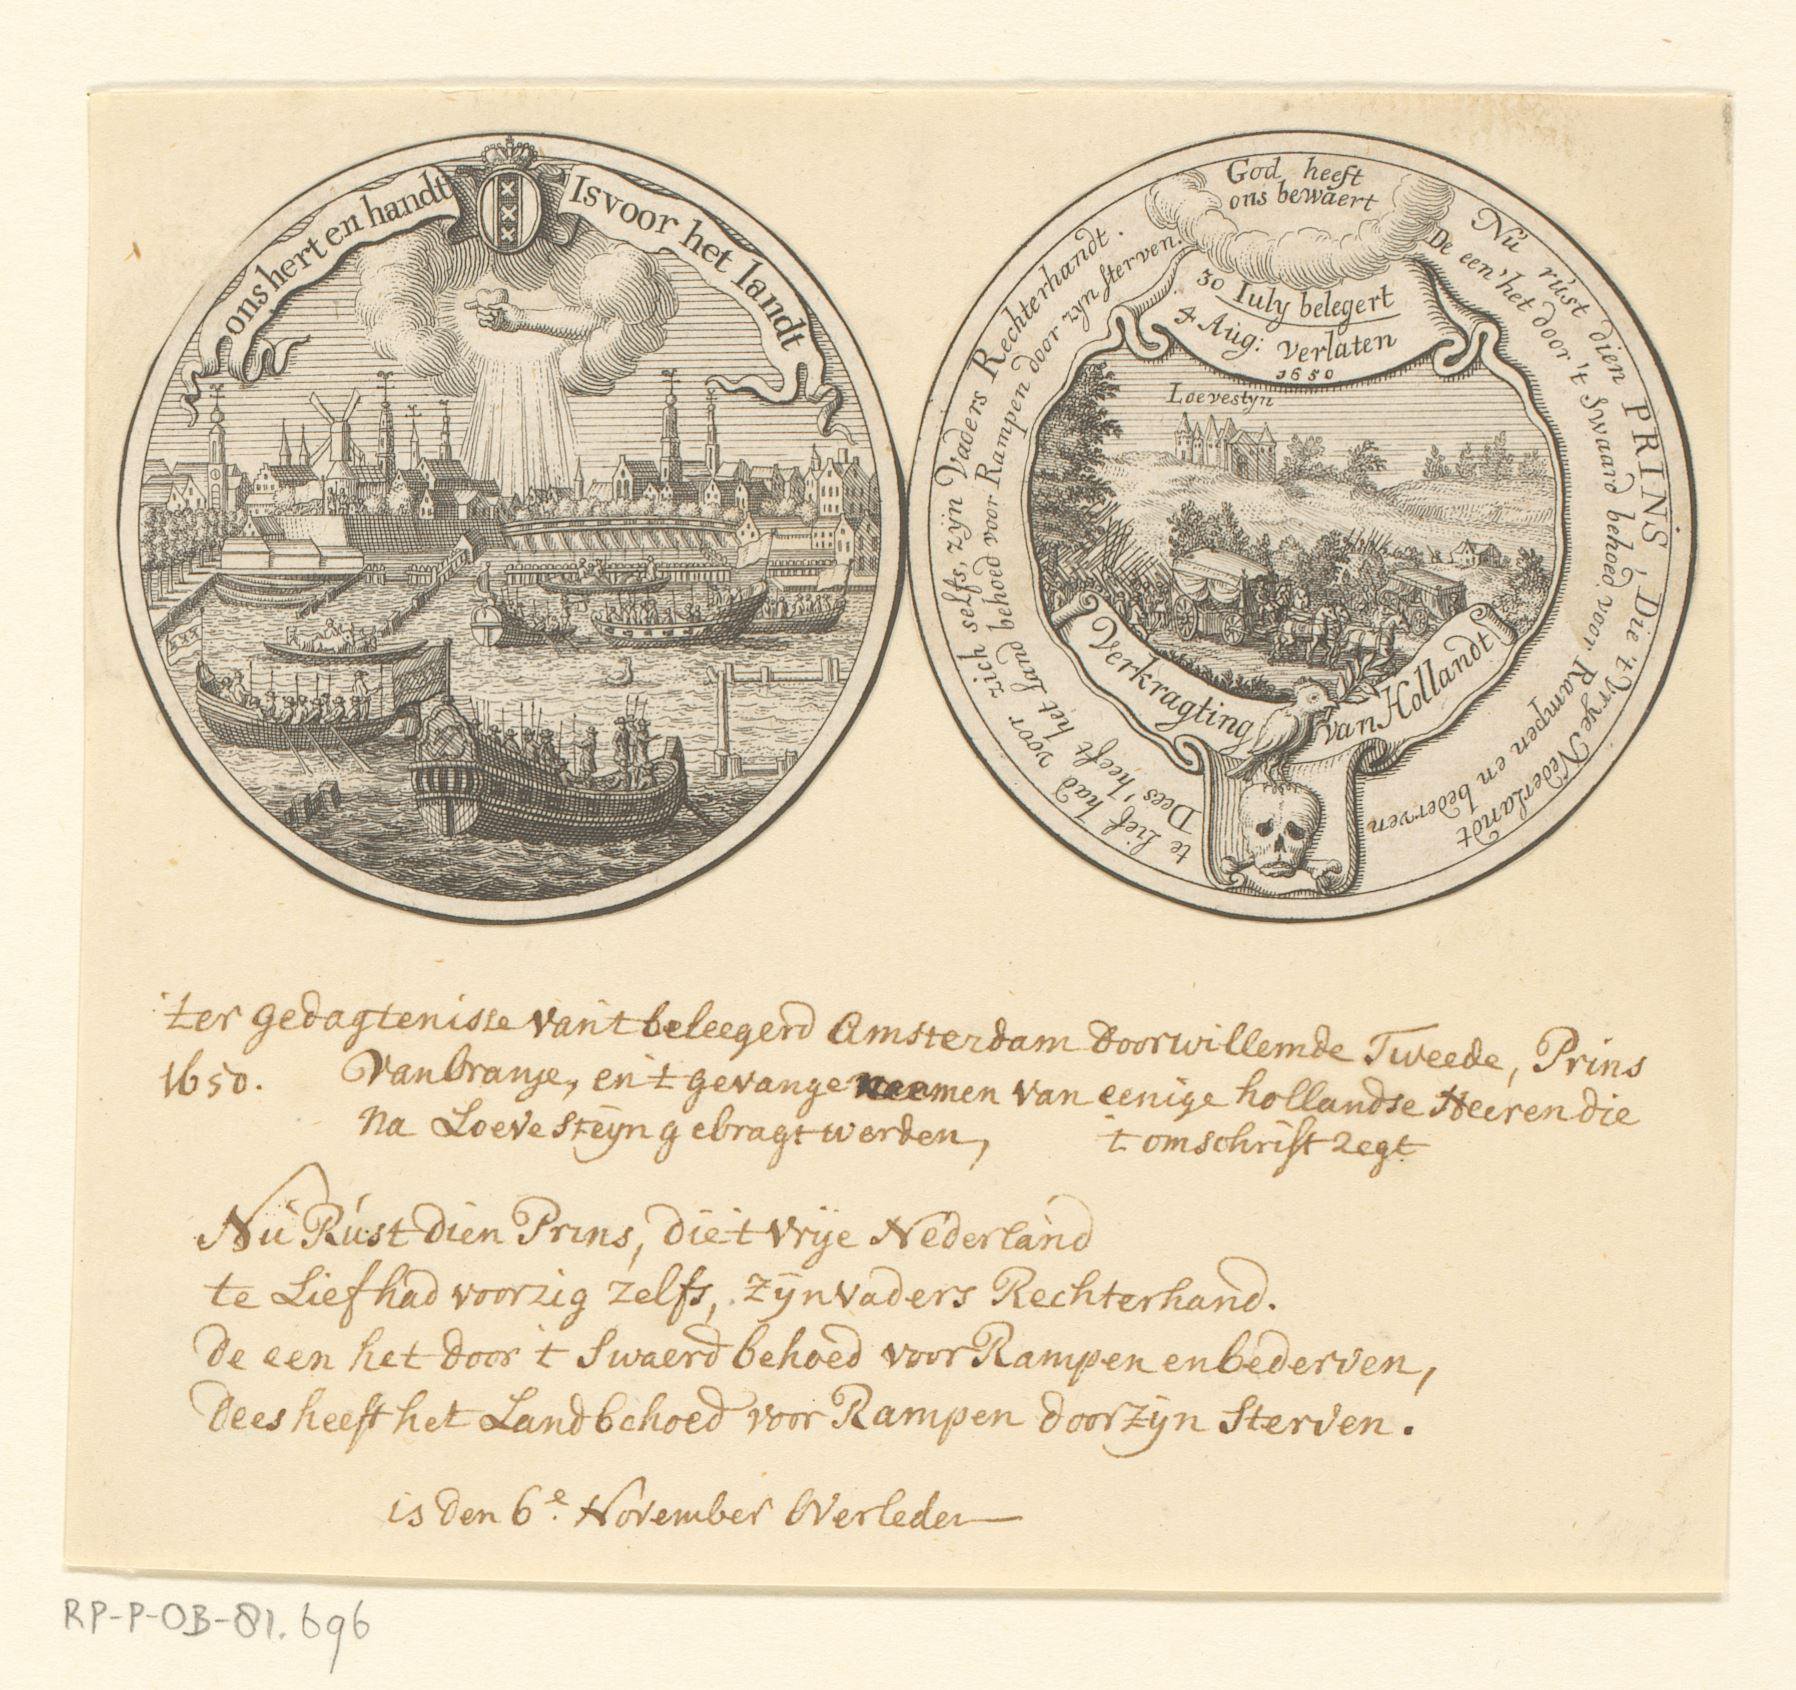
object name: print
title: Penning op het beleg van Amsterdam door Willem II, 1650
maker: Anonymous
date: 1724-1726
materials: paper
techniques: etching, writing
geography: northern netherlands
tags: william ii (prince of orange), medal (considered as a piece of sculpture, regardless of its specific function), loevestein castle, amsterdam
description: Een penning over de mislukte aanslag op Amsterdam door prins Willem II op 30 juli - 4 augustus 1650. Voorzijde: gezicht op Amsterdam en schepen op de Amstel, daarboven hand uit wolken met hart en wapenschild van de stad met wimpel met opschrift. Keerzijde: het wegvoeren van zes leden van de Staten van Holland naar het slot Loevestein en doodshoofd met duif met palmtak in bek. Uitgeknipte illustraties zonder tekst op achterzijde opgeplakt op een blad papier met annotatie.